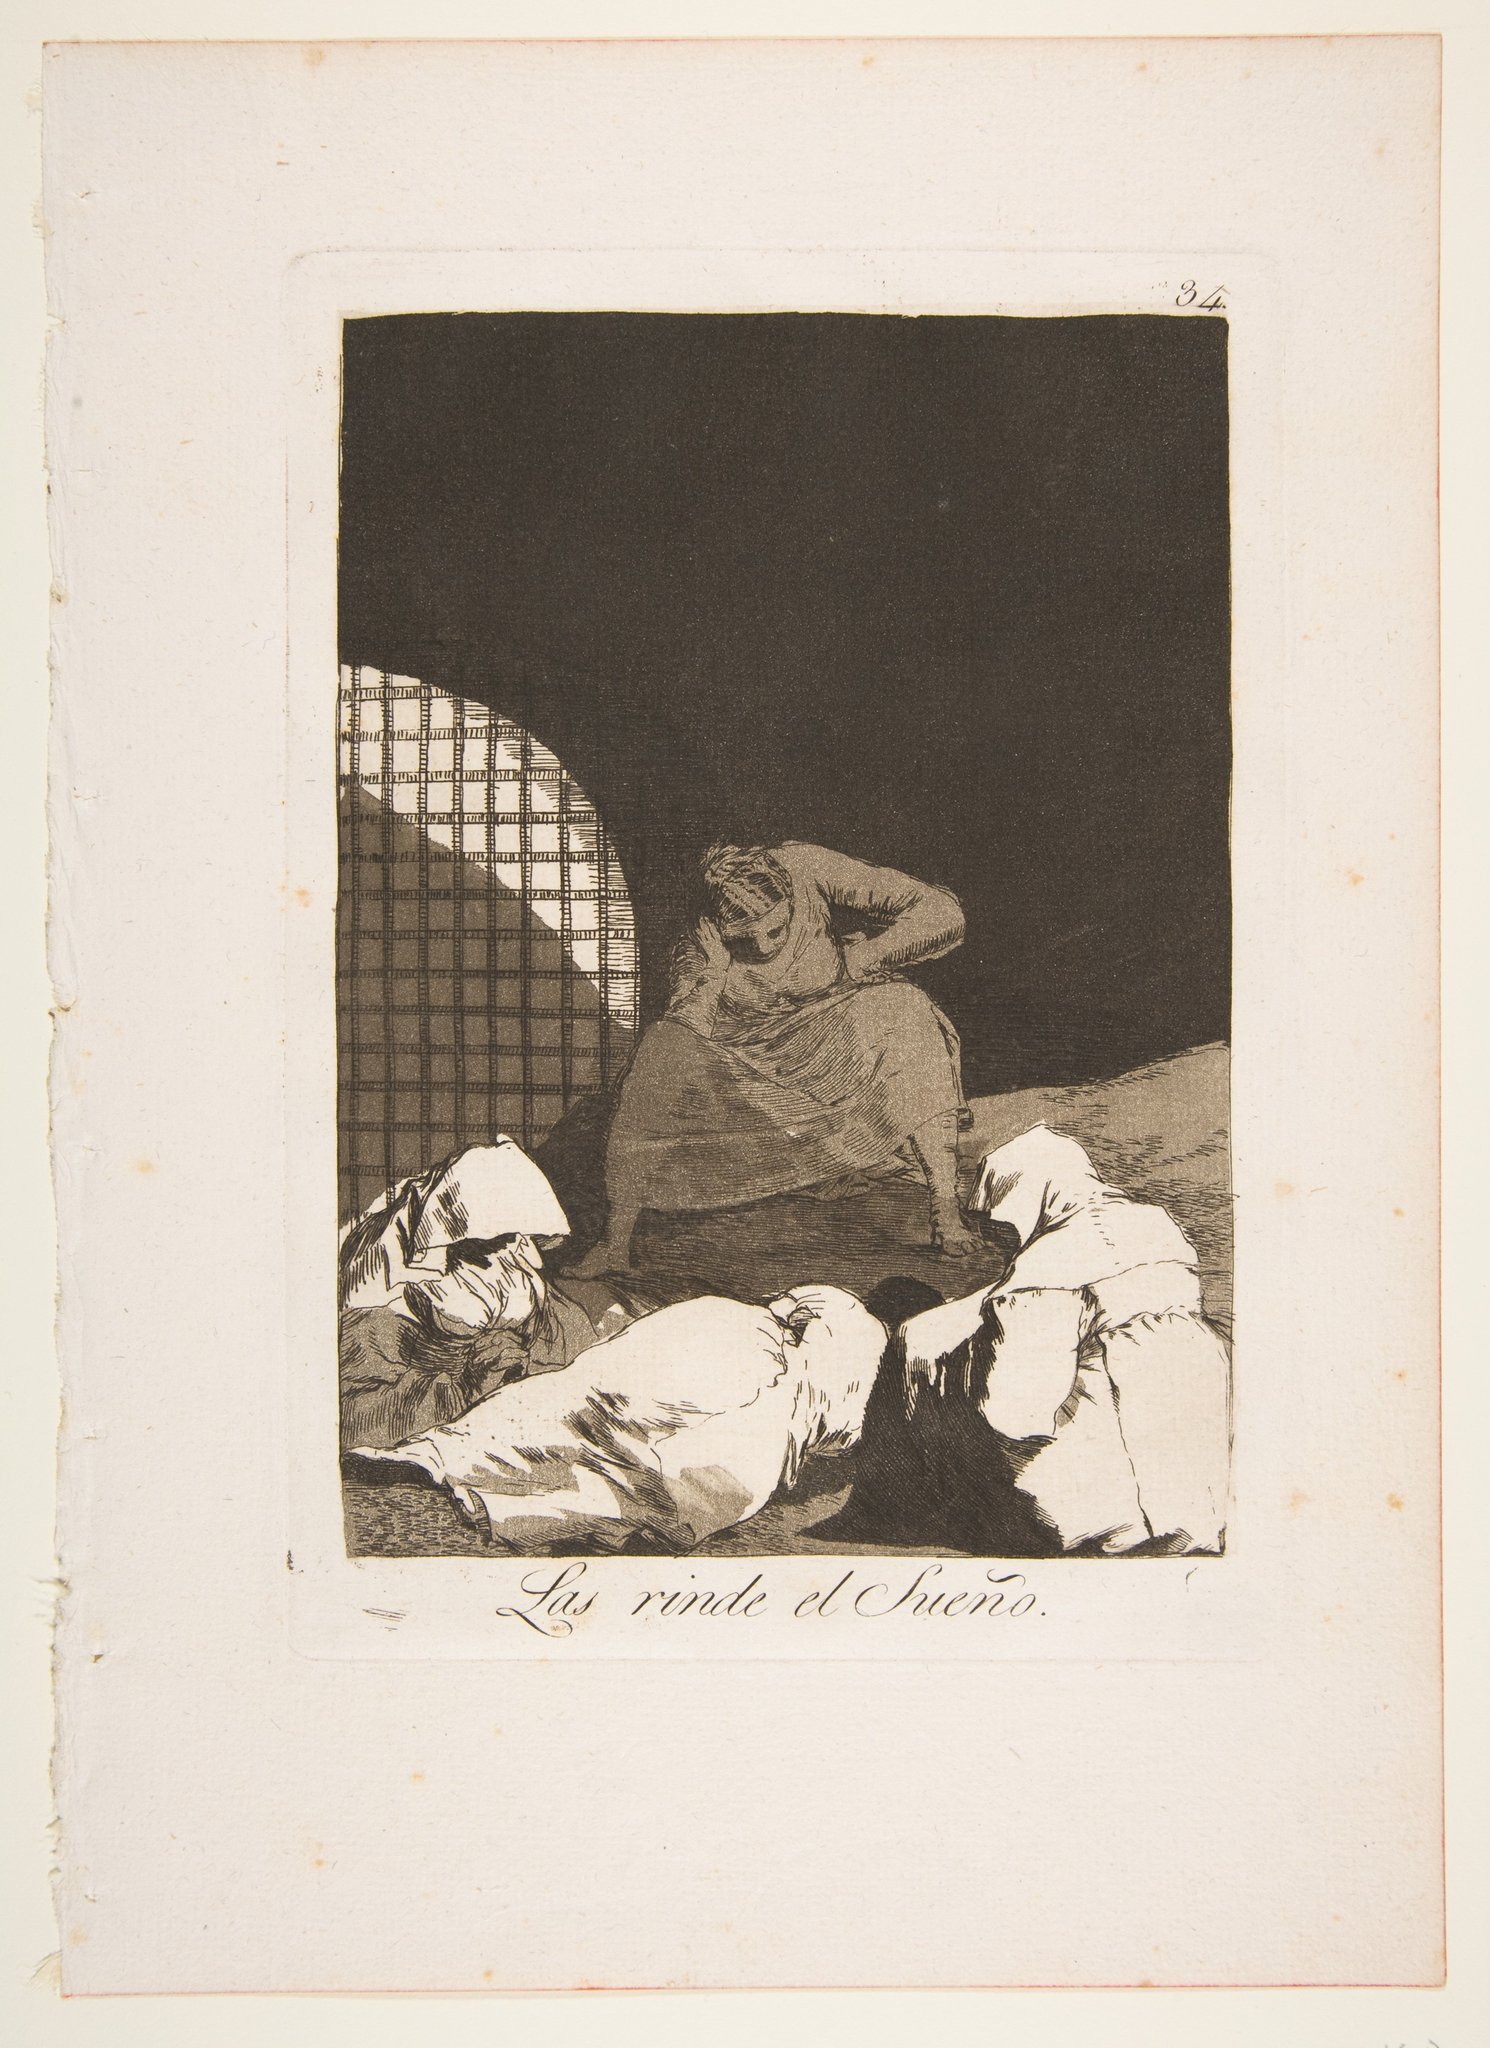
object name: print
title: Plate 34 from "Los Caprichos": Sleep overcomes them (Las rinde el Sueño)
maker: goya (francisco de goya y lucientes)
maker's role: artist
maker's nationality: spanish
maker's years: 1746-1828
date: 1799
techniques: aquatint, burnishing, etching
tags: sleeping,women